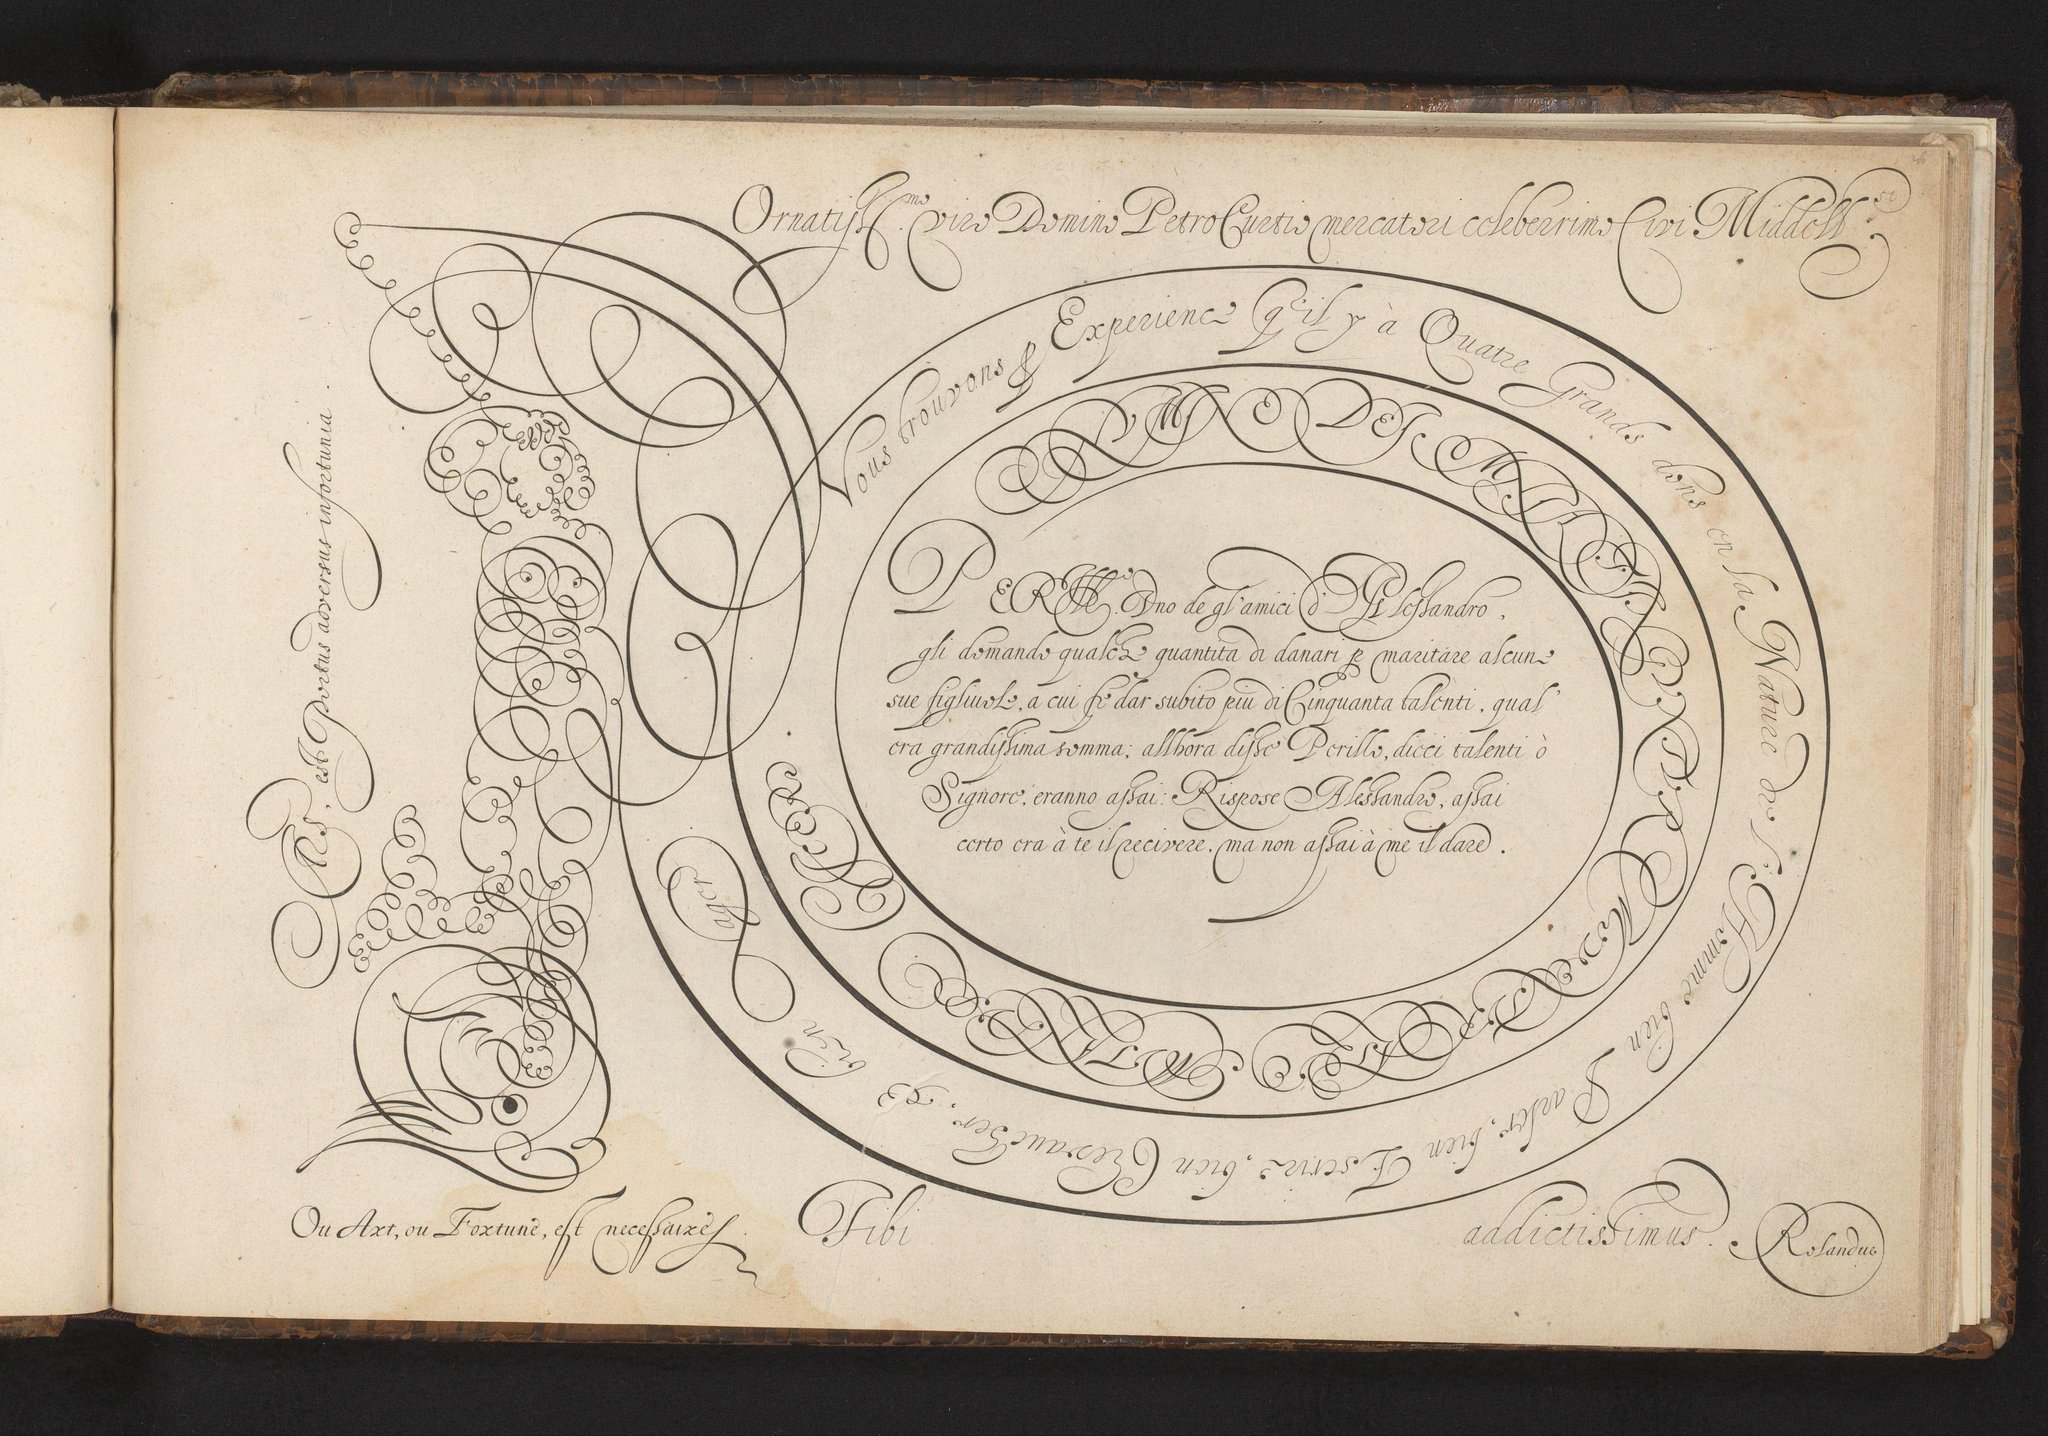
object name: album leaf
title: Schrijfvoorbeeld met Fortuna in krulwerk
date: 1616-1617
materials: paper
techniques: engraving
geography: flushing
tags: calligraphy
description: Schrijfvoorbeeld met Fortuna staande op een vis en met een zeil in haar handen, in krulwerk. Daarbij zes regels tekst in het Italiaans: Per ill uno de gl'amici d'Alessandro en een tekst in een spiraal geschreven. Bovenaan een opdracht aan Pieter Courten, koopman in Middelburg. De prent maakt deel uit van een album.